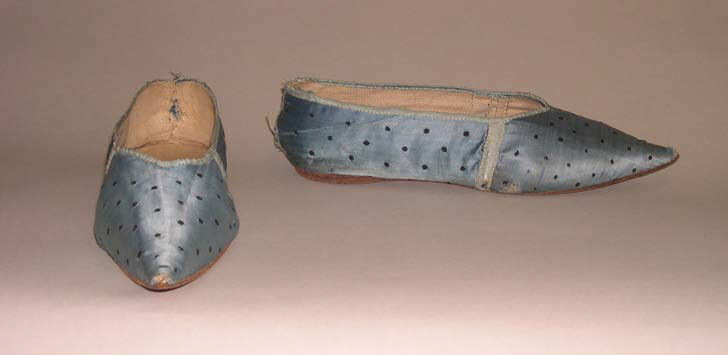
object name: slipper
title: Slippers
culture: american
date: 1790-1799